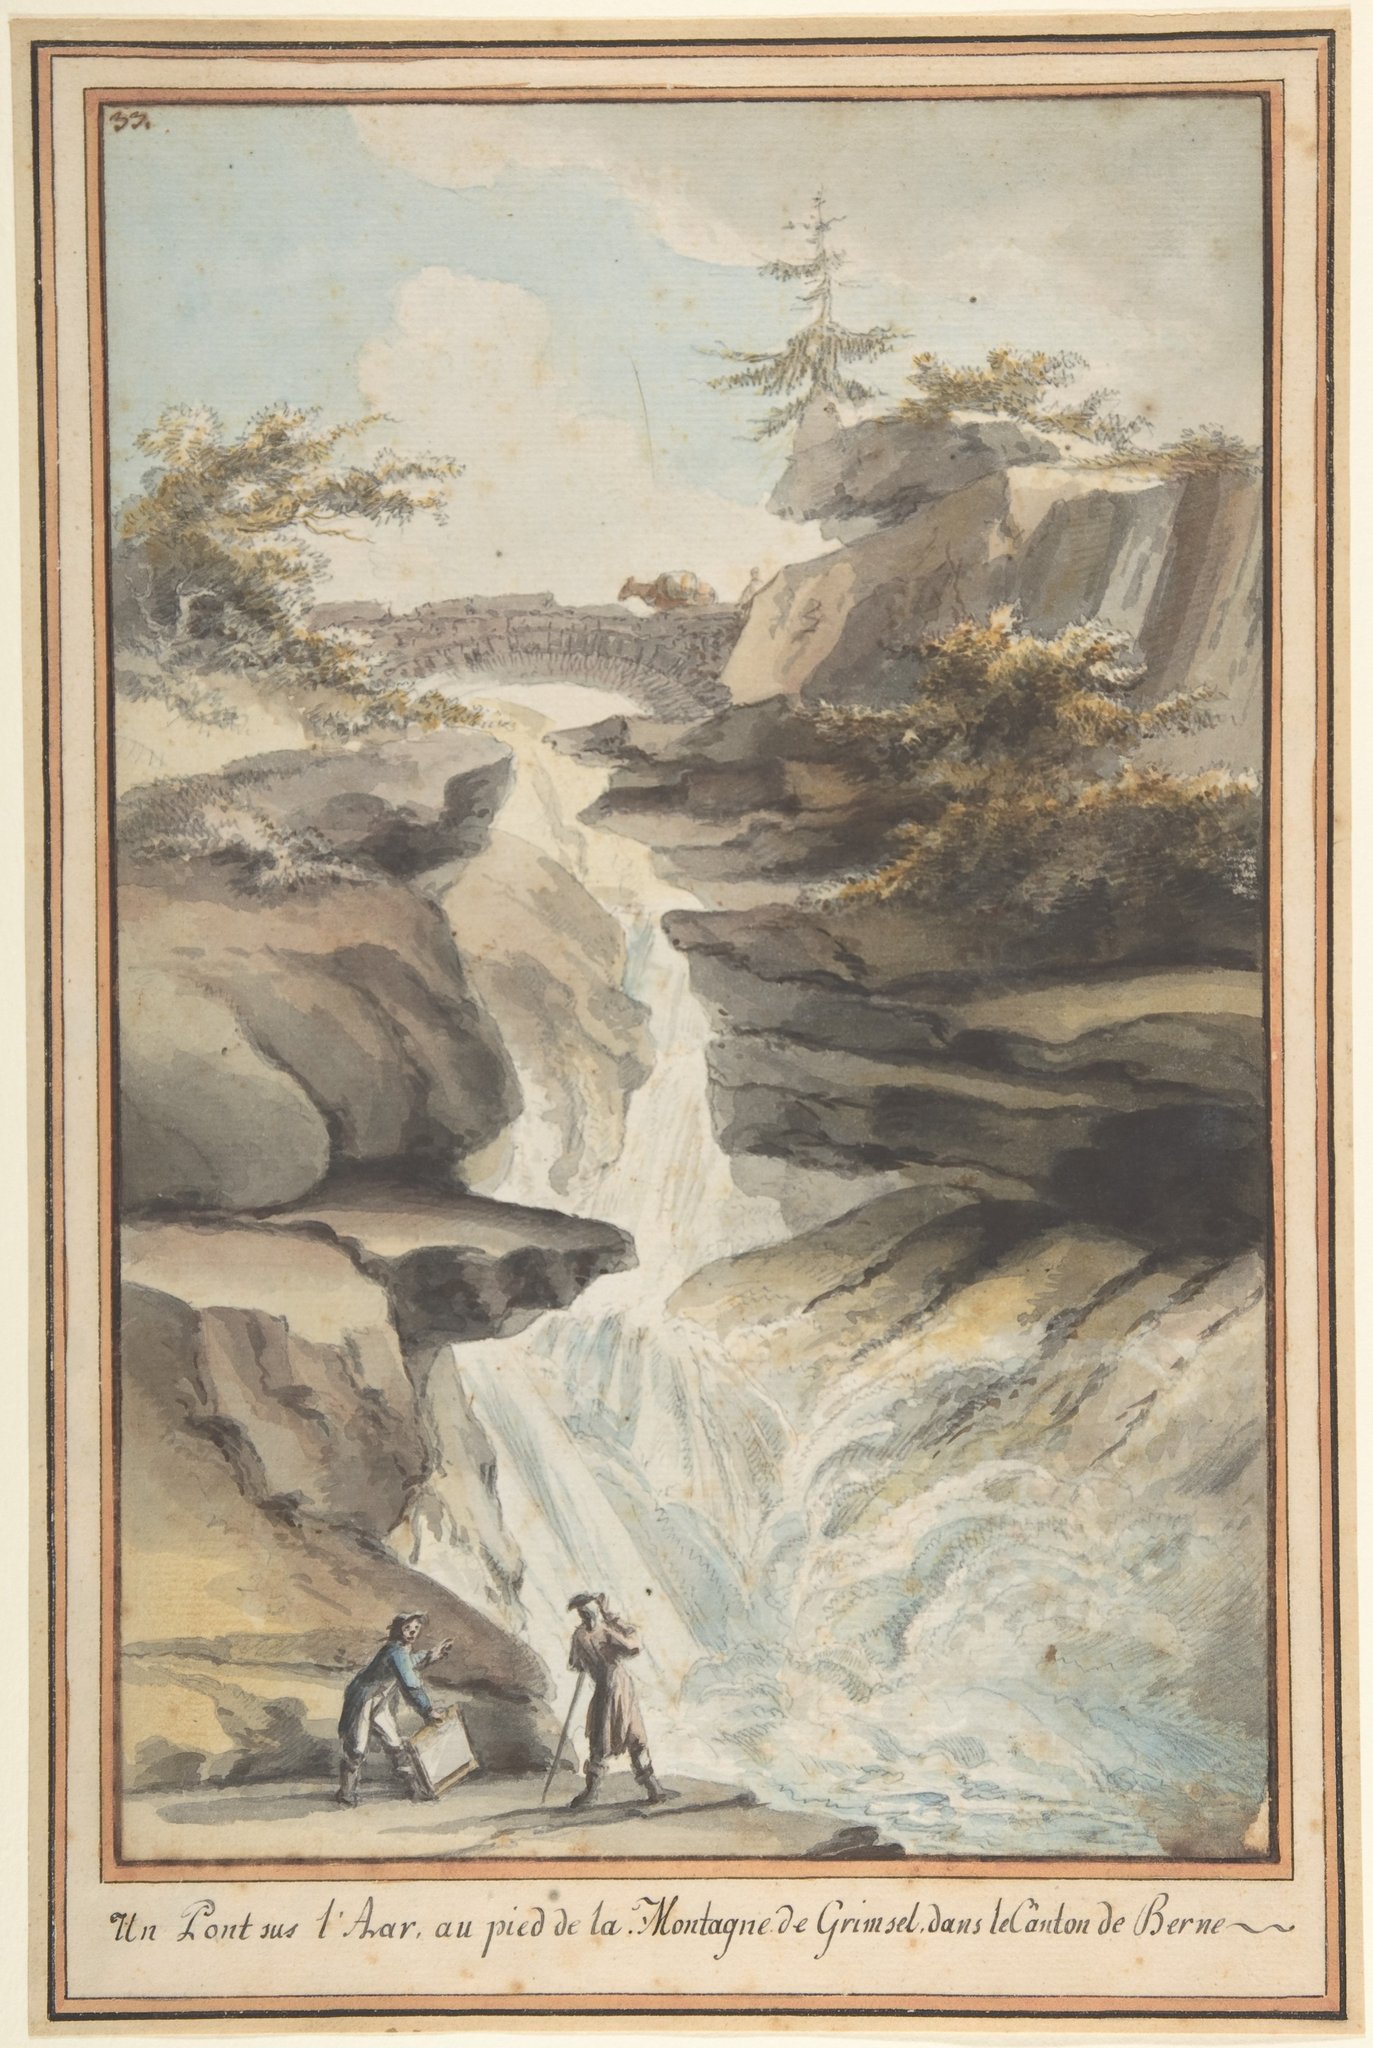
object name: drawing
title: A Bridge on the Aar, at the Foot of the Grimsel, in the Canton of Berne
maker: caspar wolf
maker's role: artist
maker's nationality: swiss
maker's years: 1735-1783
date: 1775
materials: ink, pencil, watercolor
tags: human figures,bridges,waterfalls